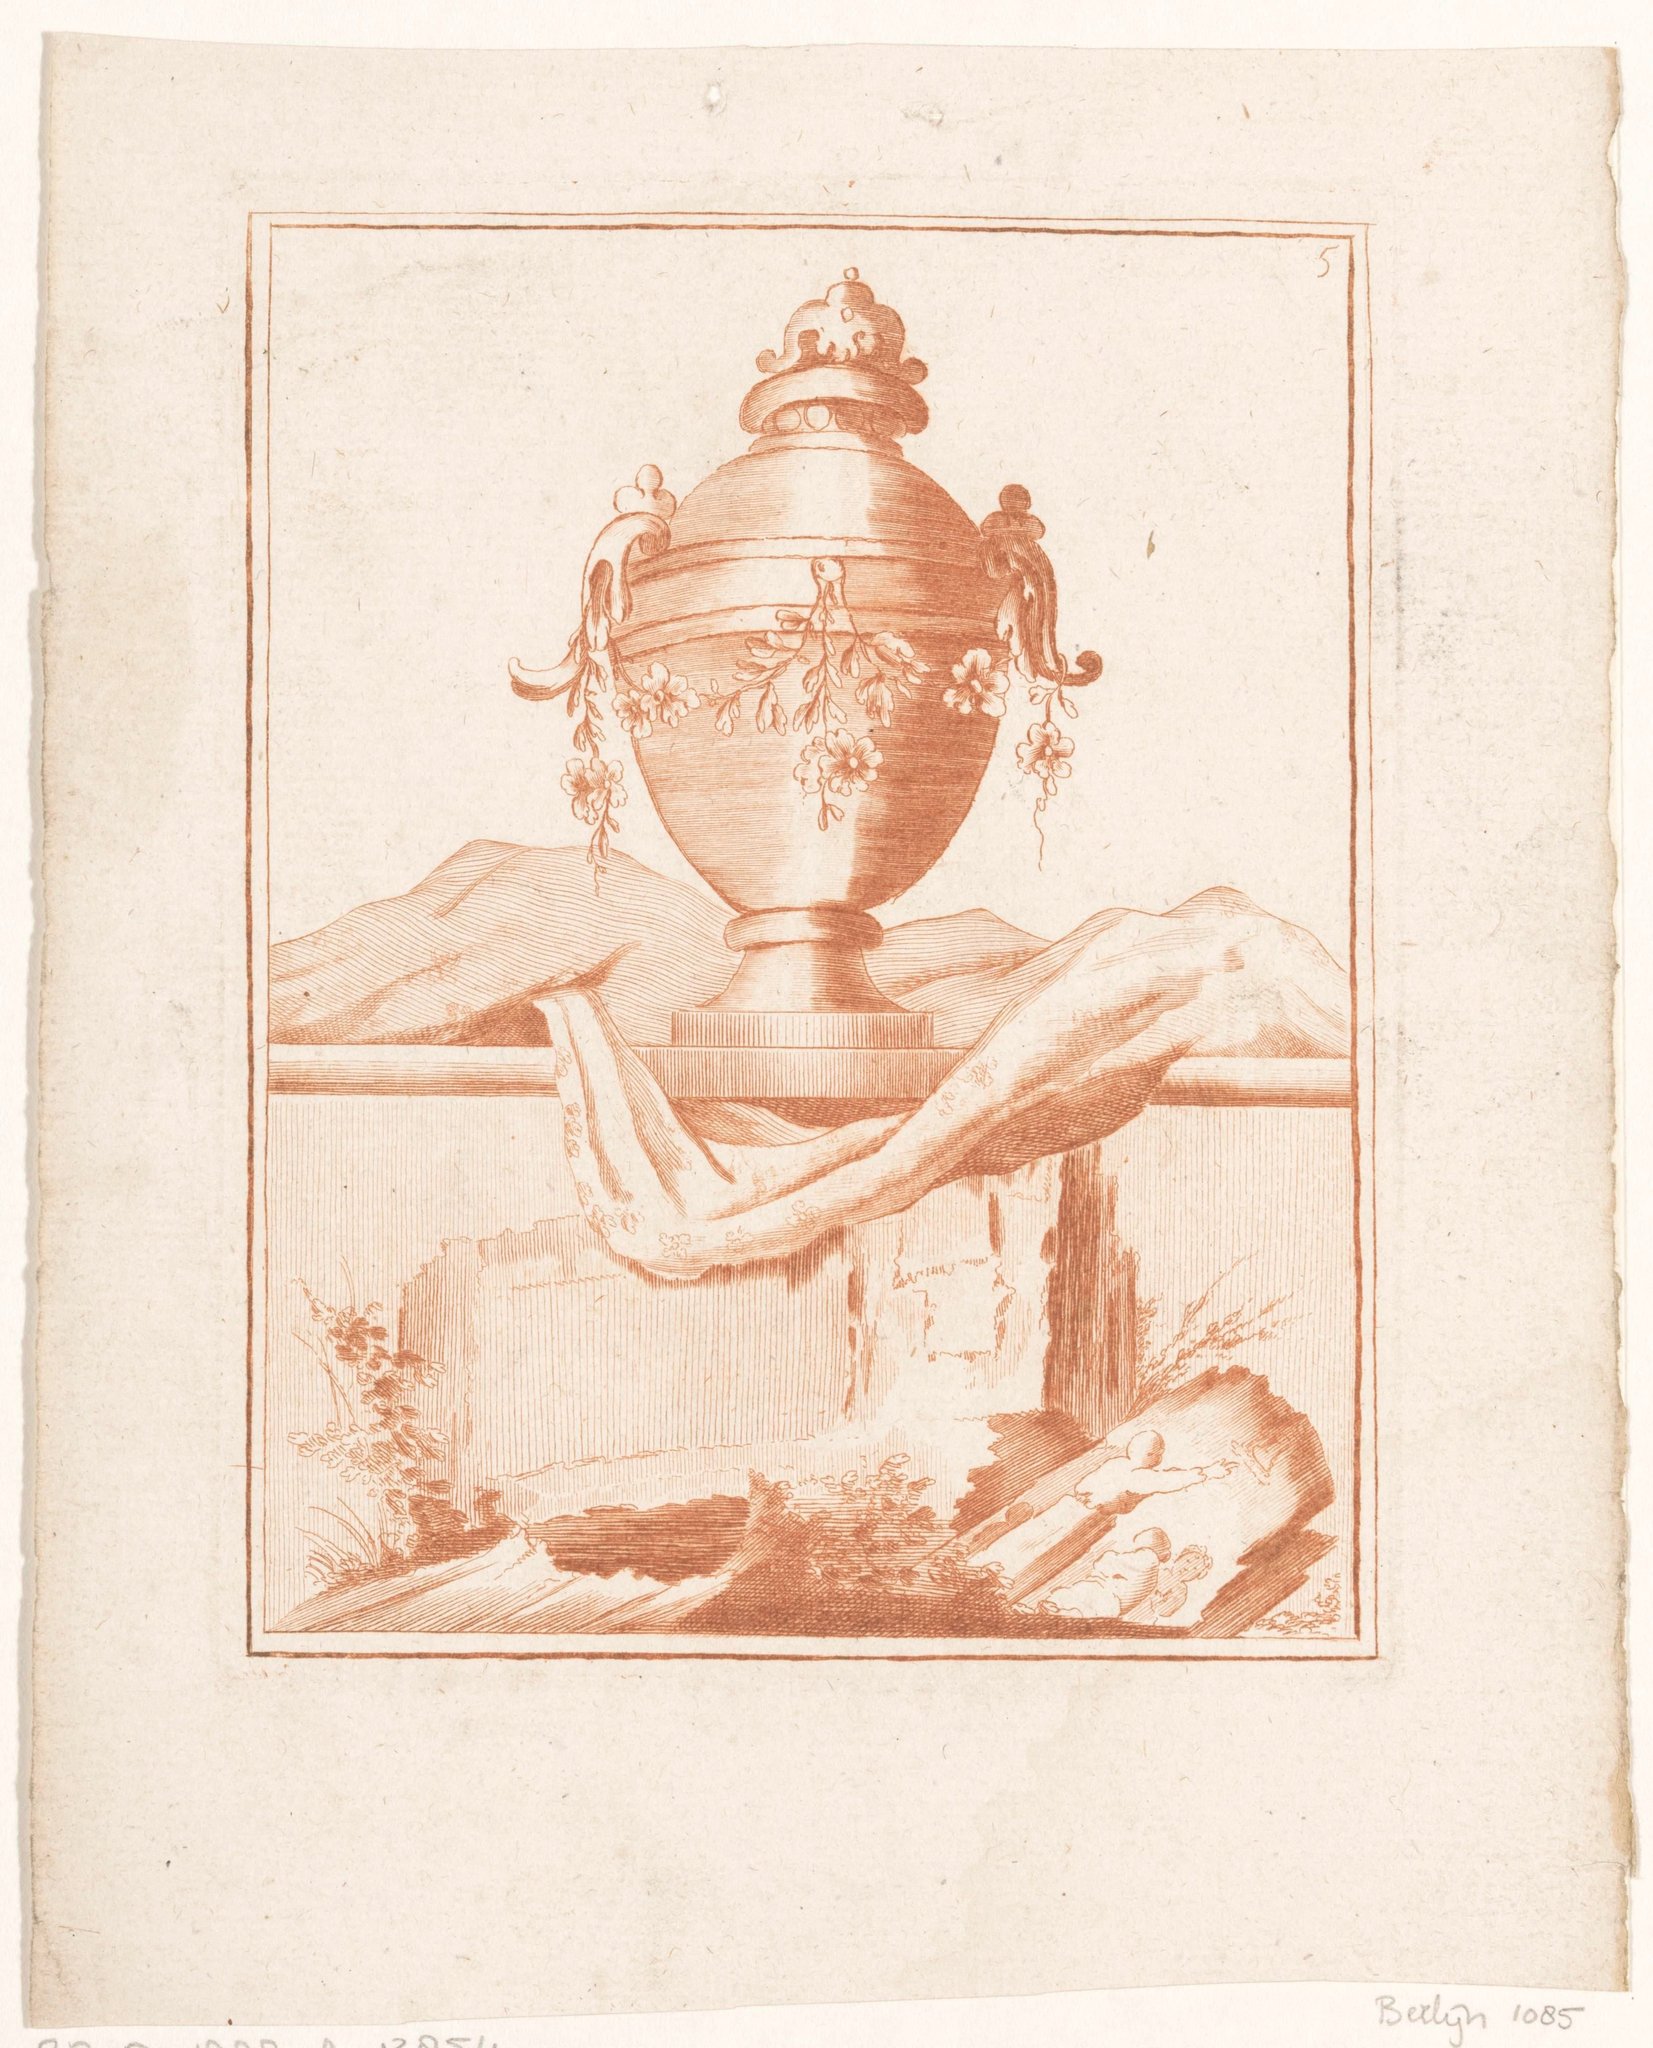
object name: ornament print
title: Vaas en doeken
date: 1768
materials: paper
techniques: etching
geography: paris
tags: vase ~ ornament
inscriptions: collector's mark: Lugt 2228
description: Een geornamenteerde vaas met bloemen, rondom liggen doeken gedrapeerd.